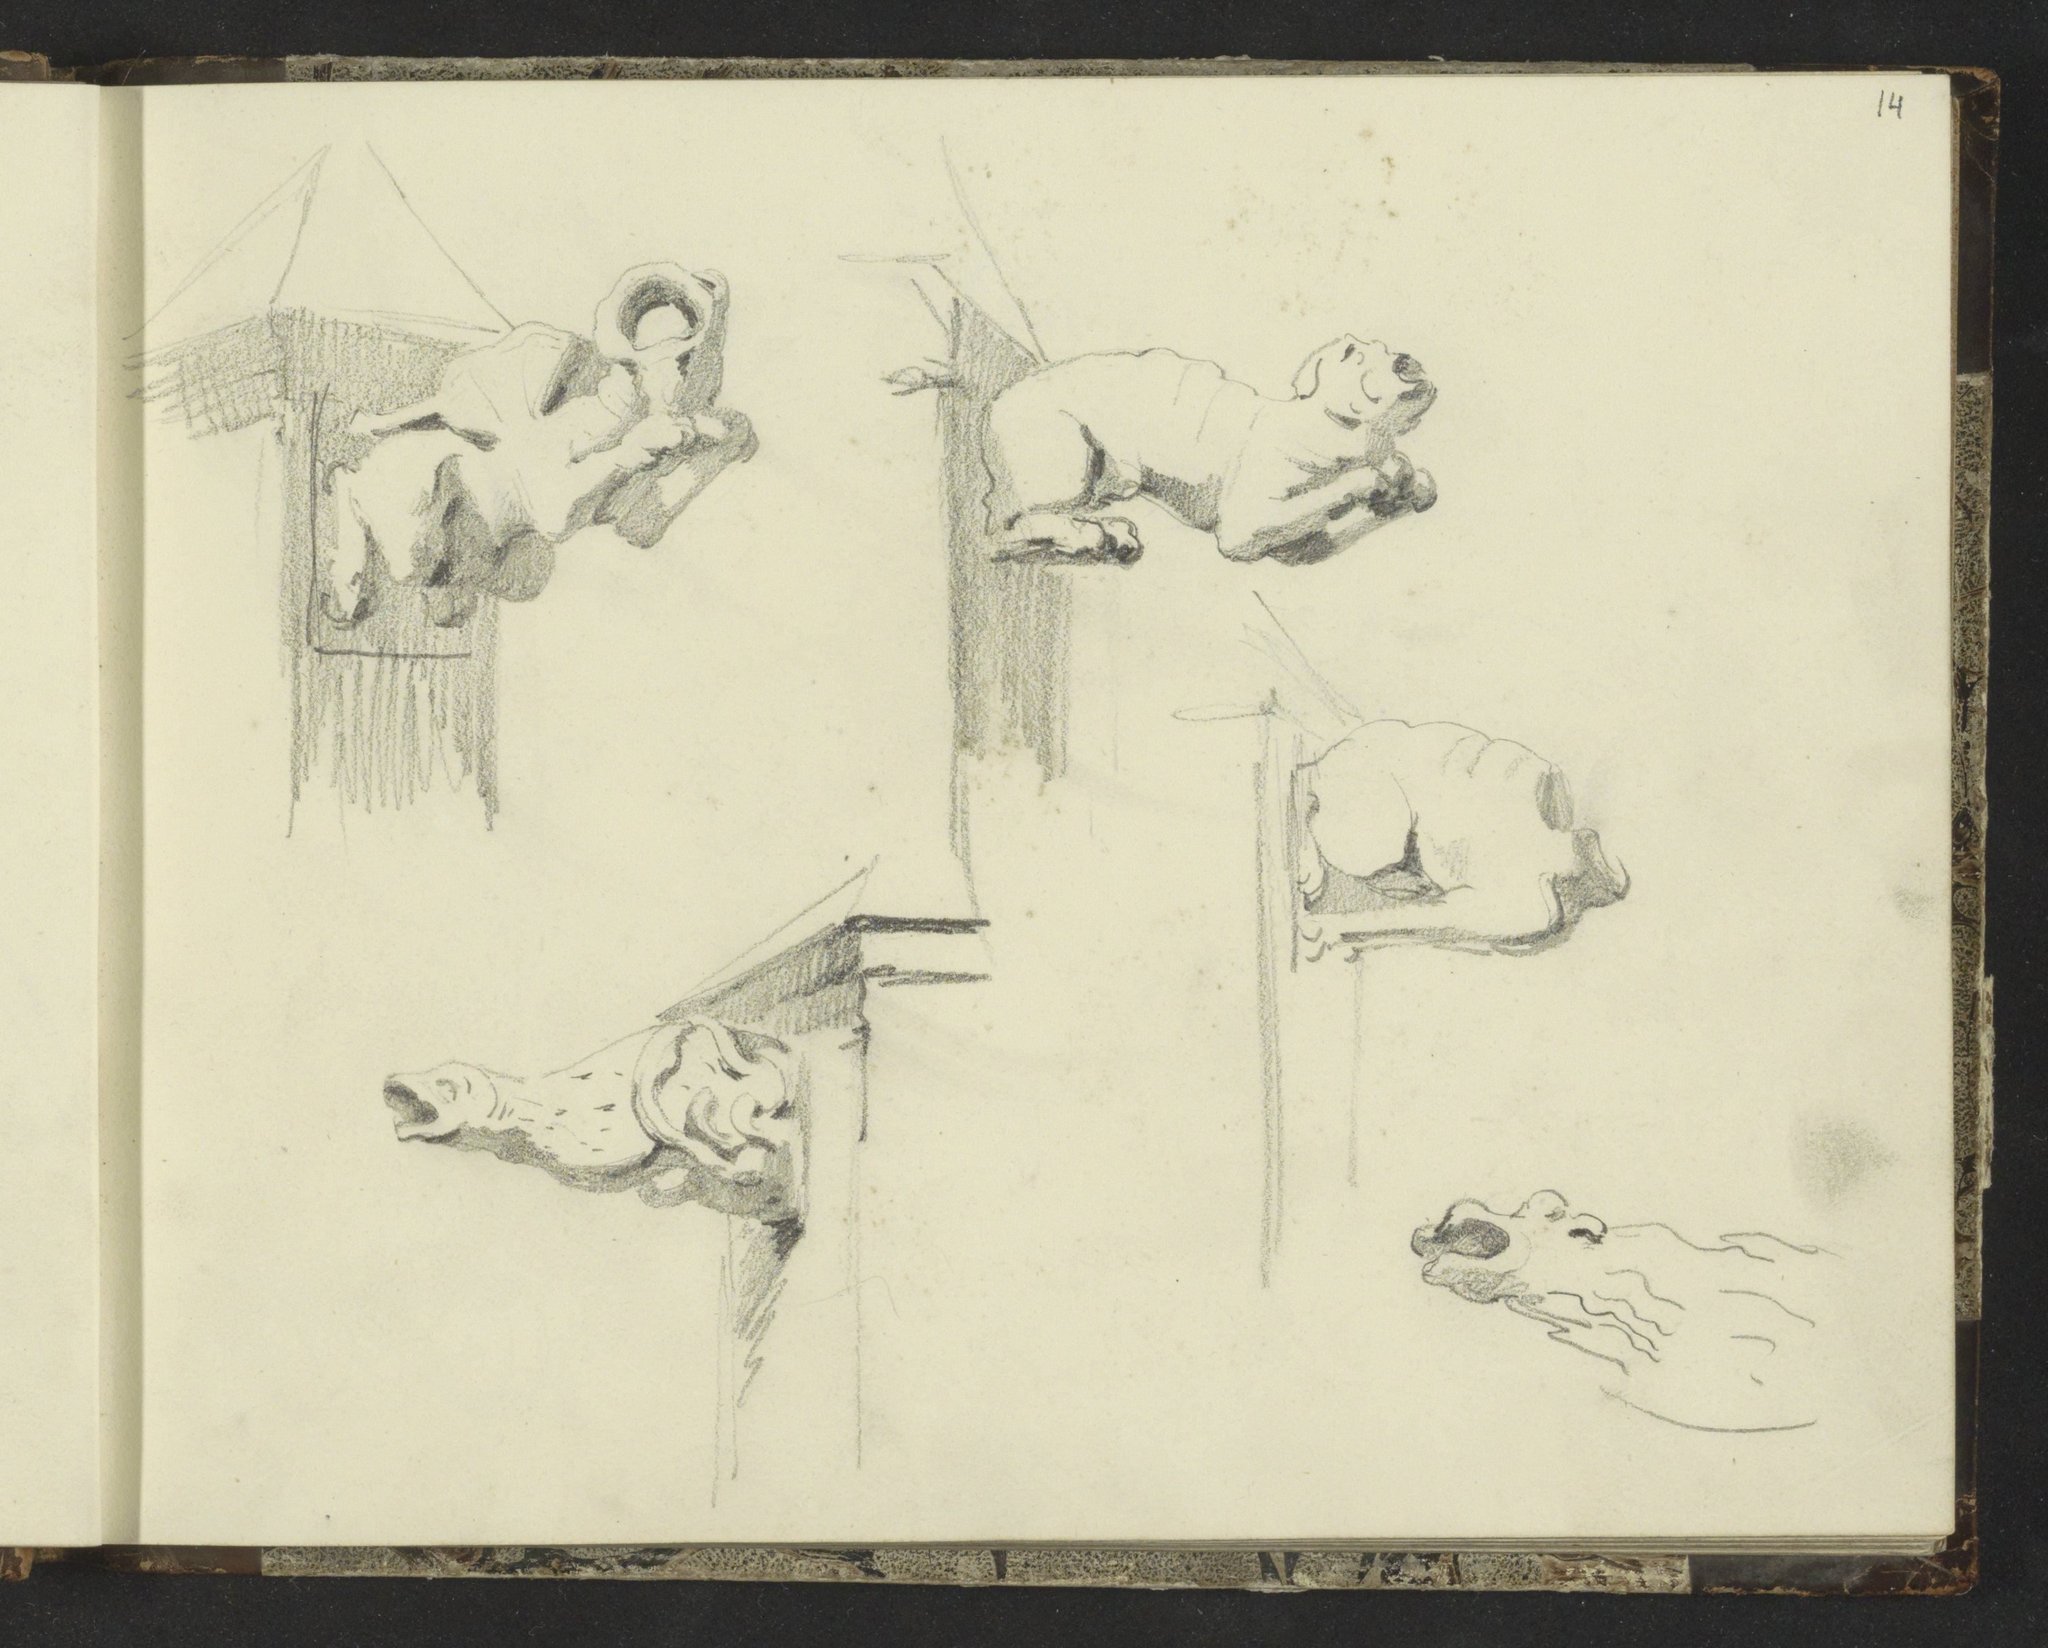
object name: sketchbook leaf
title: Waterspuwers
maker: willem hendrik schmidt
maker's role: draughtsman, painter, print maker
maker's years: 1809-1849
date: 1819-1849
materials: paper, pencil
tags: ornament ~ grotesque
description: Blad 14 recto uit een schetsboek met 58 bladen.